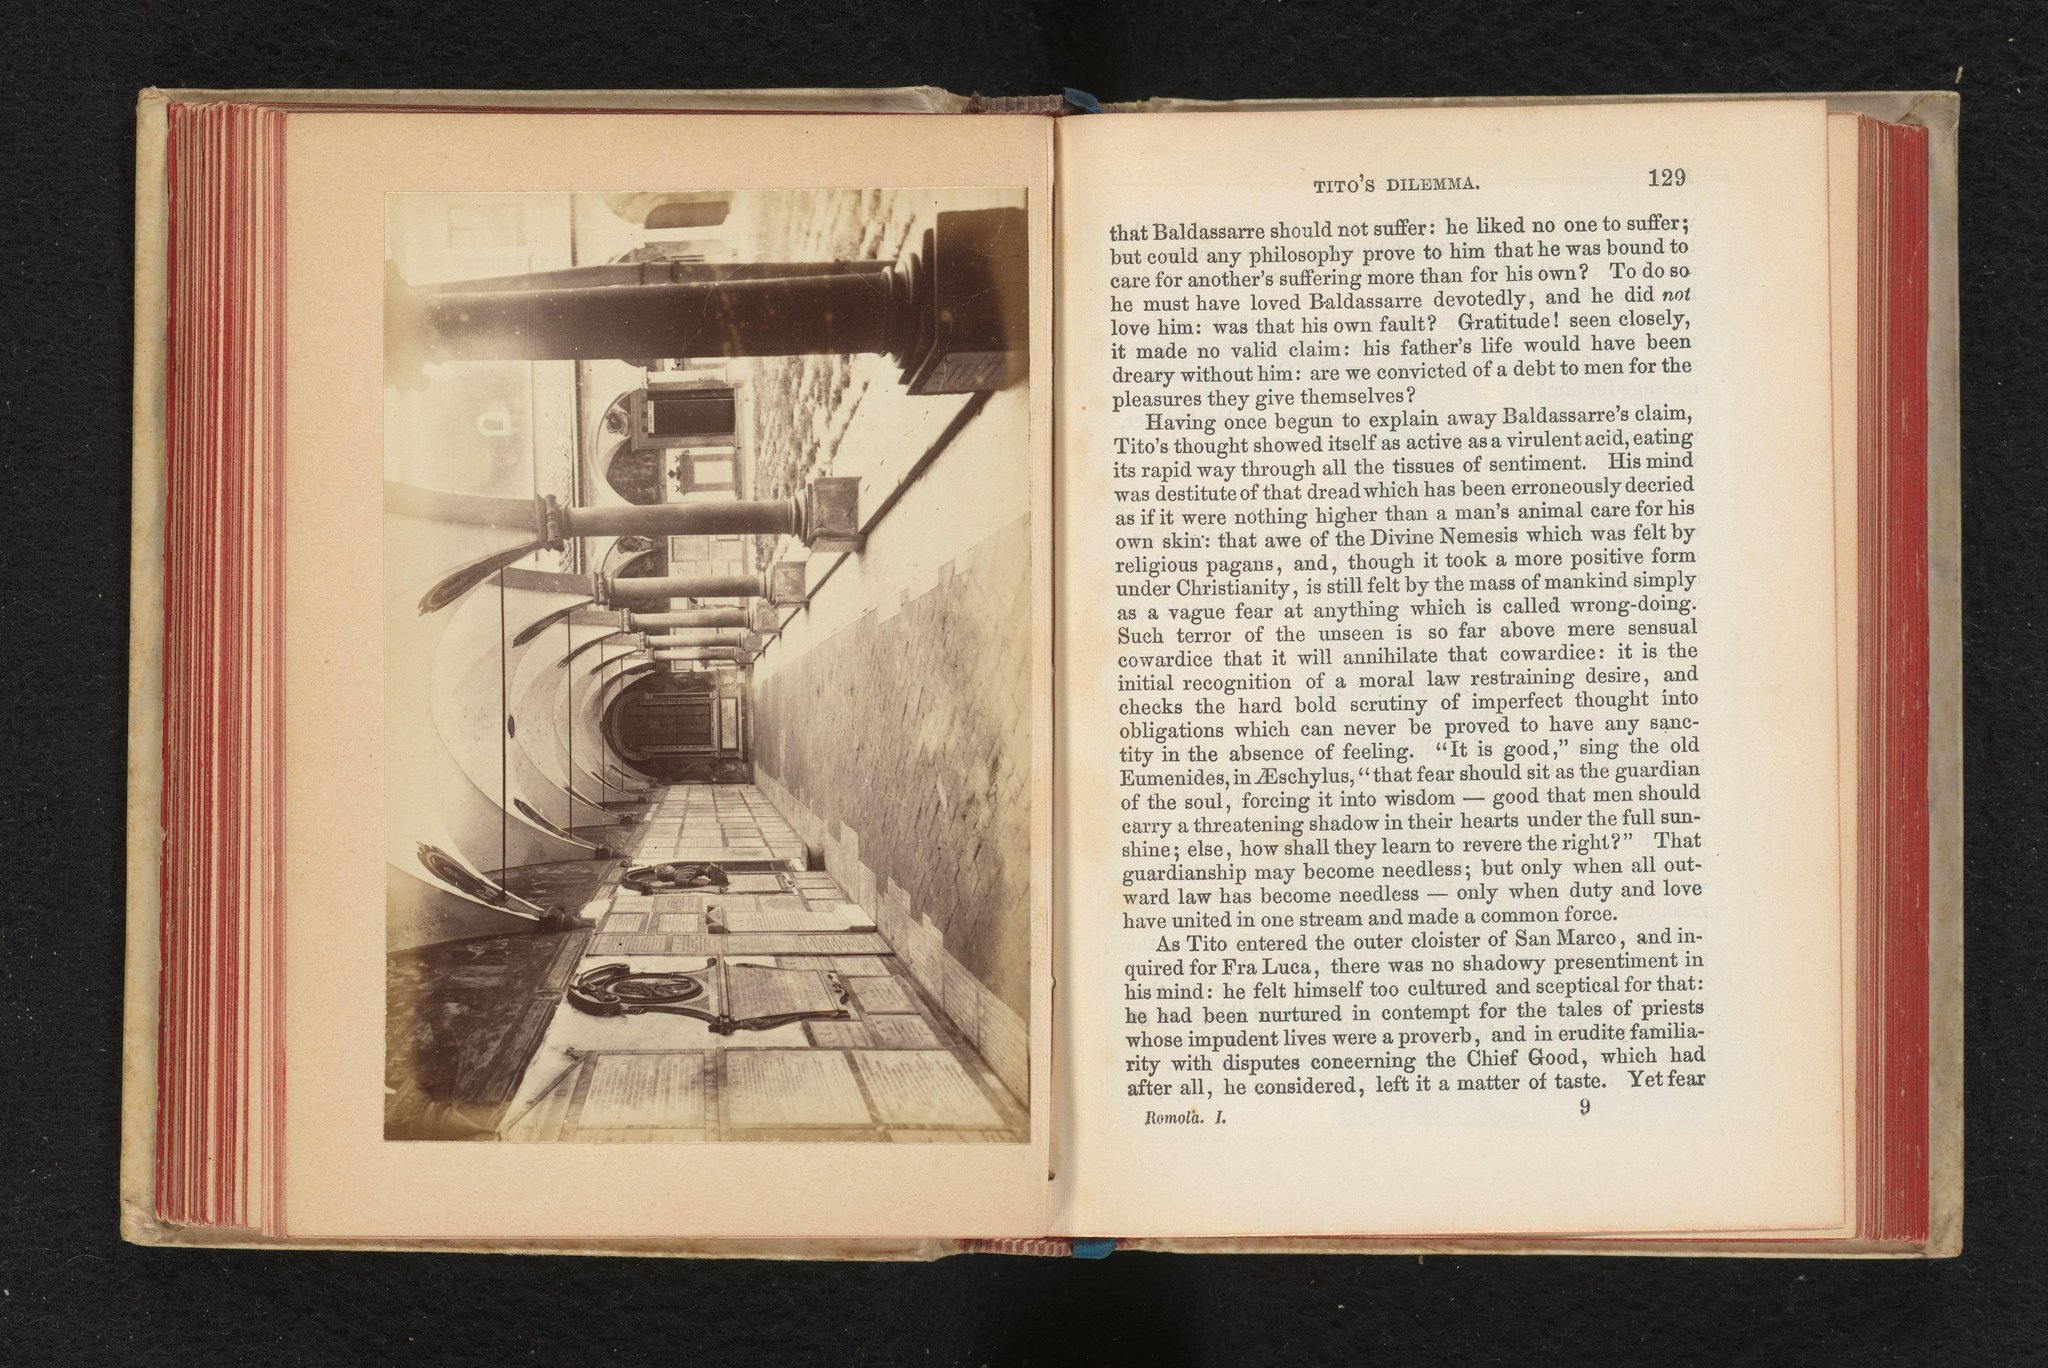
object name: photograph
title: Kloostergang van het klooster van San Marco, Florence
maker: giacomo brogi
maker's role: fotograaf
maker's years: 1822-1881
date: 1858-1863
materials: paper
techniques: albumen print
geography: florence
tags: cloisters ~ monastery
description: Foto op ongenummerde pagina tegenover pagina 129.